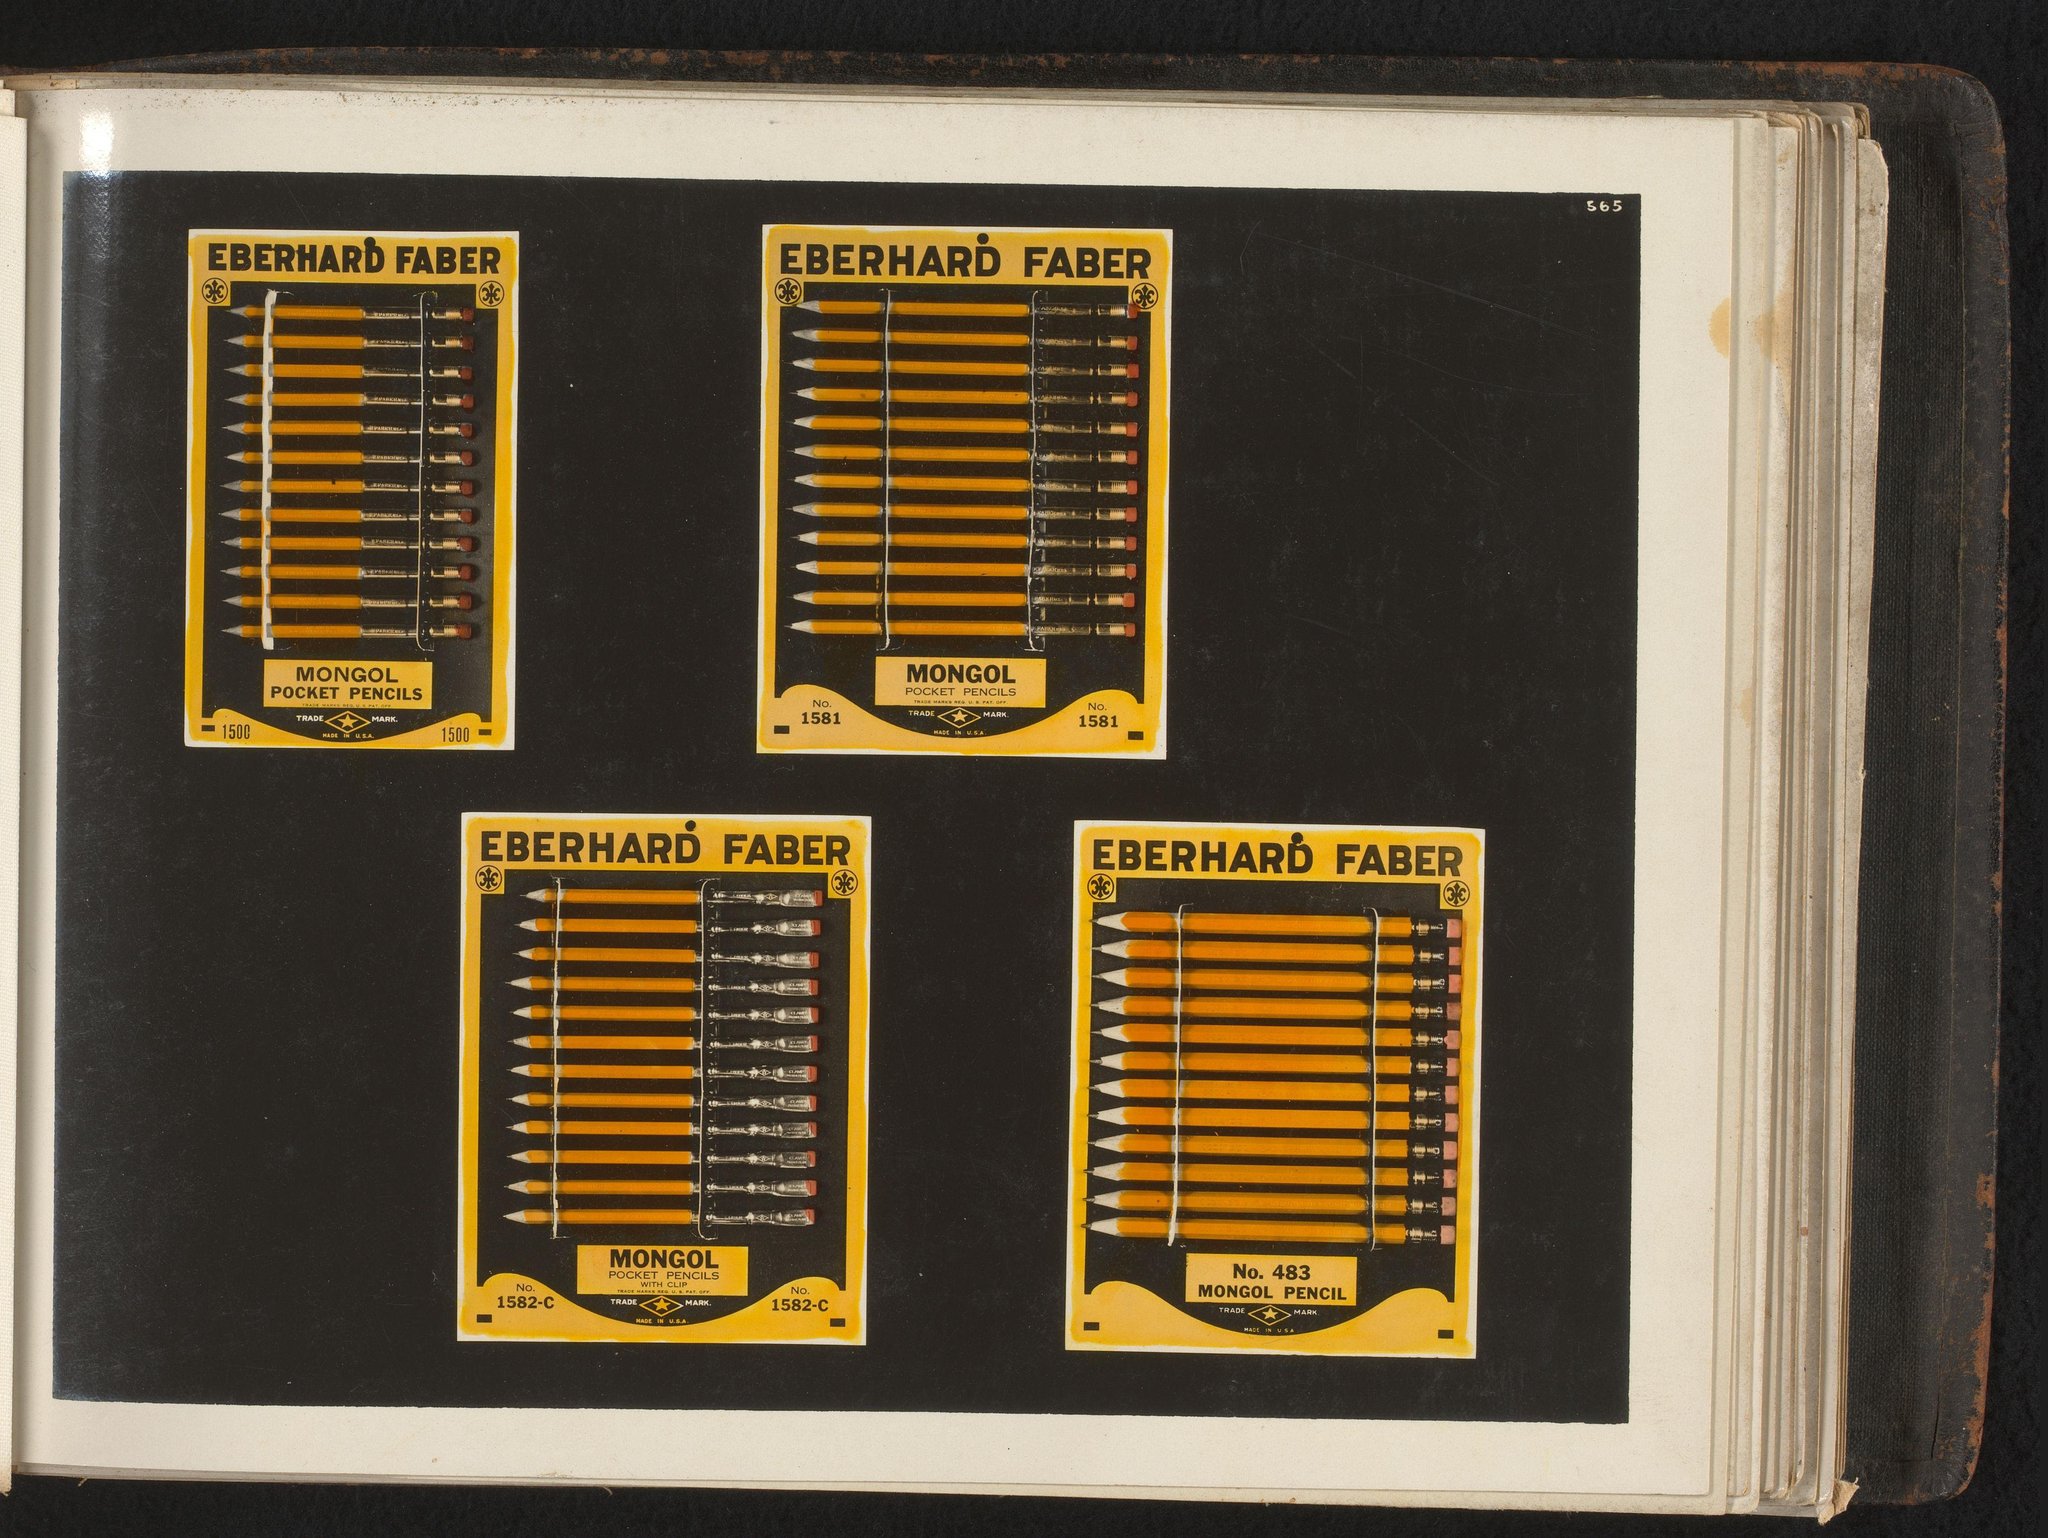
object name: photograph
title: Sets met potloden van Eberhard Faber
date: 1915-1935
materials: paper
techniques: gelatin silver print, hand coloring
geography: springfield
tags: pencil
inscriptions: number: ‘565’, stamp: ‘Paramount/ Commercial Studios/ 145 Chestnut St./ Springfield - Mass.’